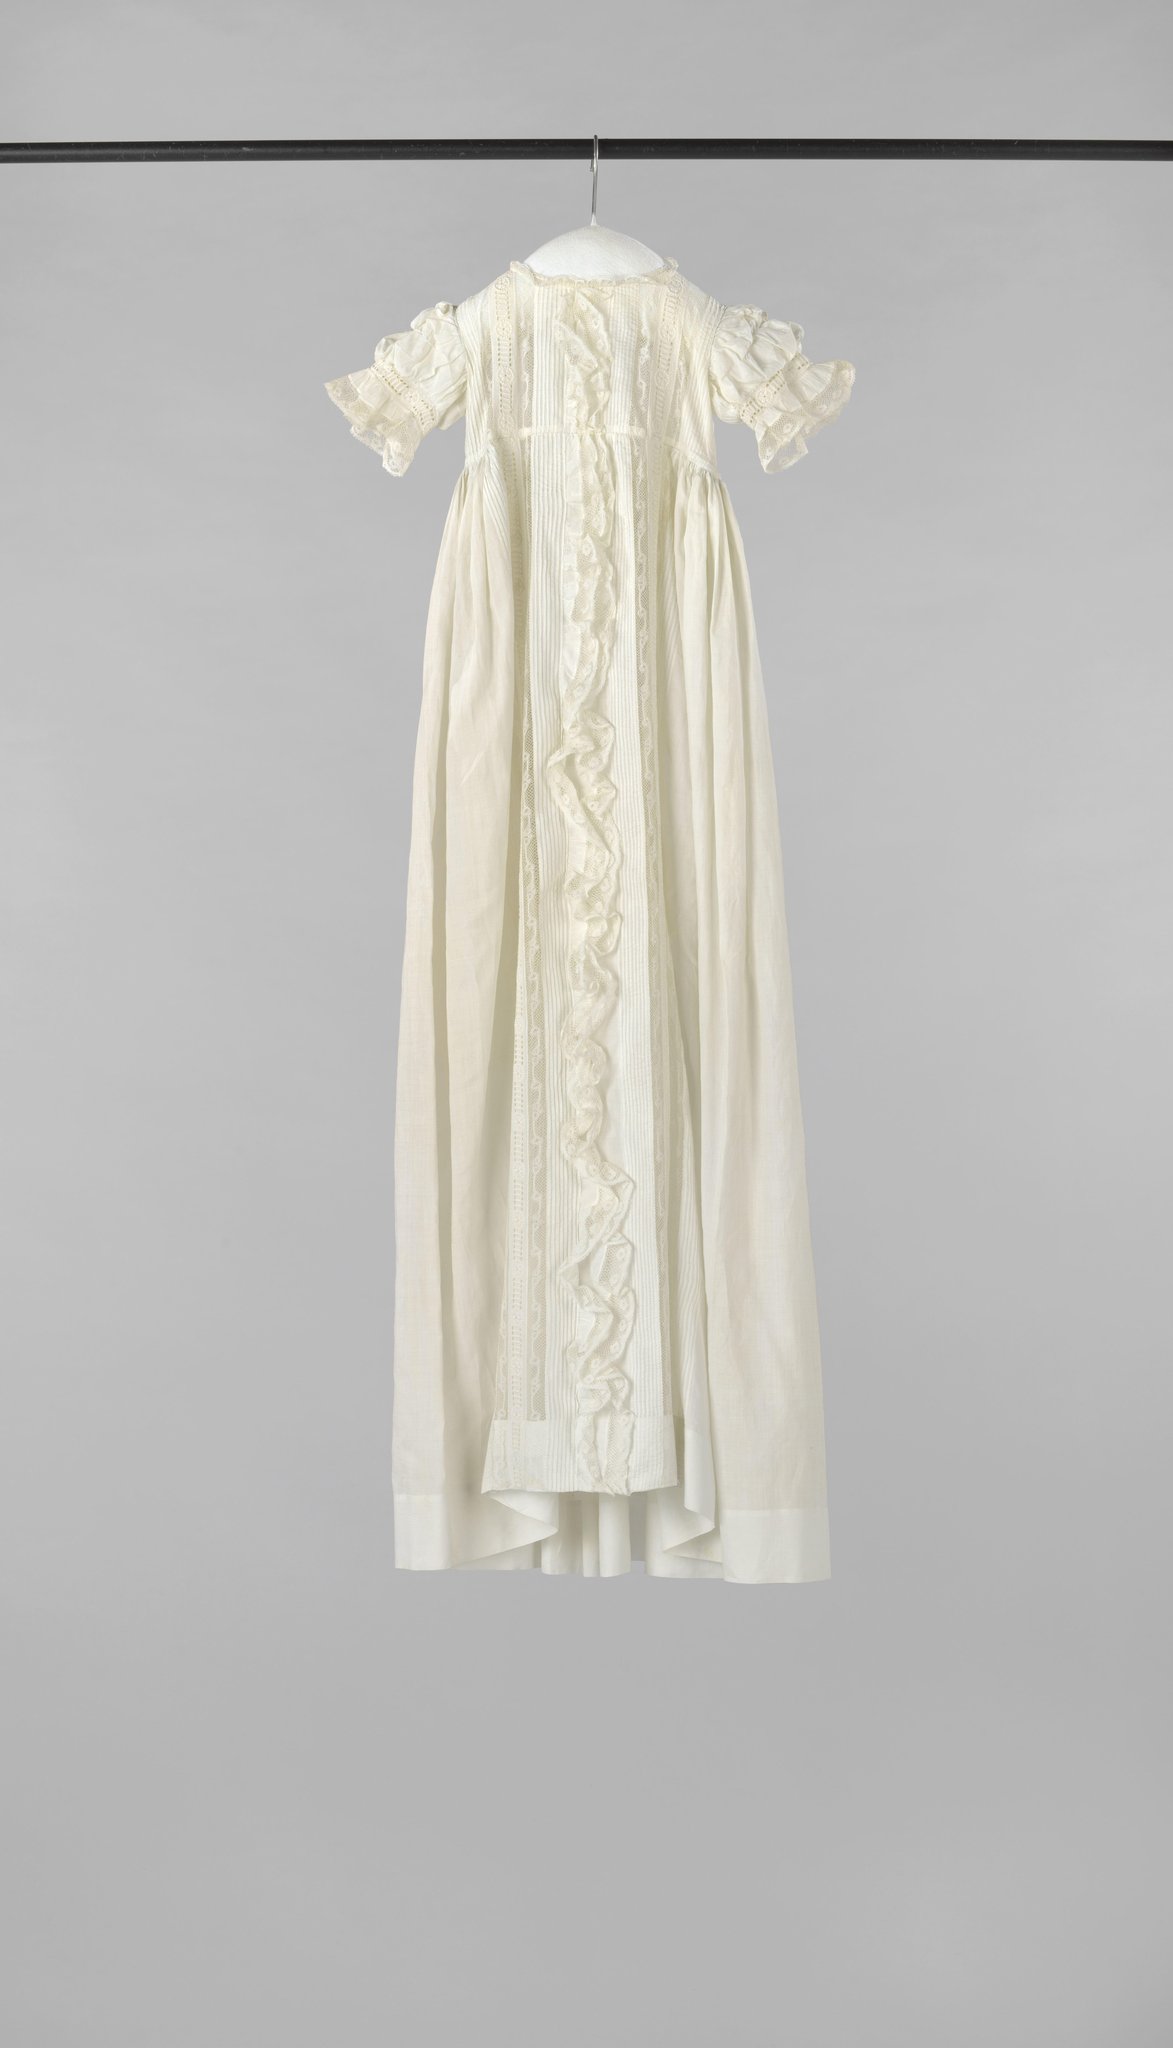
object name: doopjurk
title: Witte doopjurk met korte mouwen die zijn afgezet met stroken Valenciennes-kant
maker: Anonymous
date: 1850-1930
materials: cotton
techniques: embroidered, lace, embroidery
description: Aan de voorzijde verticaal over de gehele lengte twee ruches van Valenciennes-kant. Aan weerszijden daarvan een verticaal geplaatste tussenzetsel met witwerk en en twee rijen oprijgjes over de gehele lengte. Rond de taille twee tunnels met daardoorheen witte linten die sluiten aan de achterzijde.